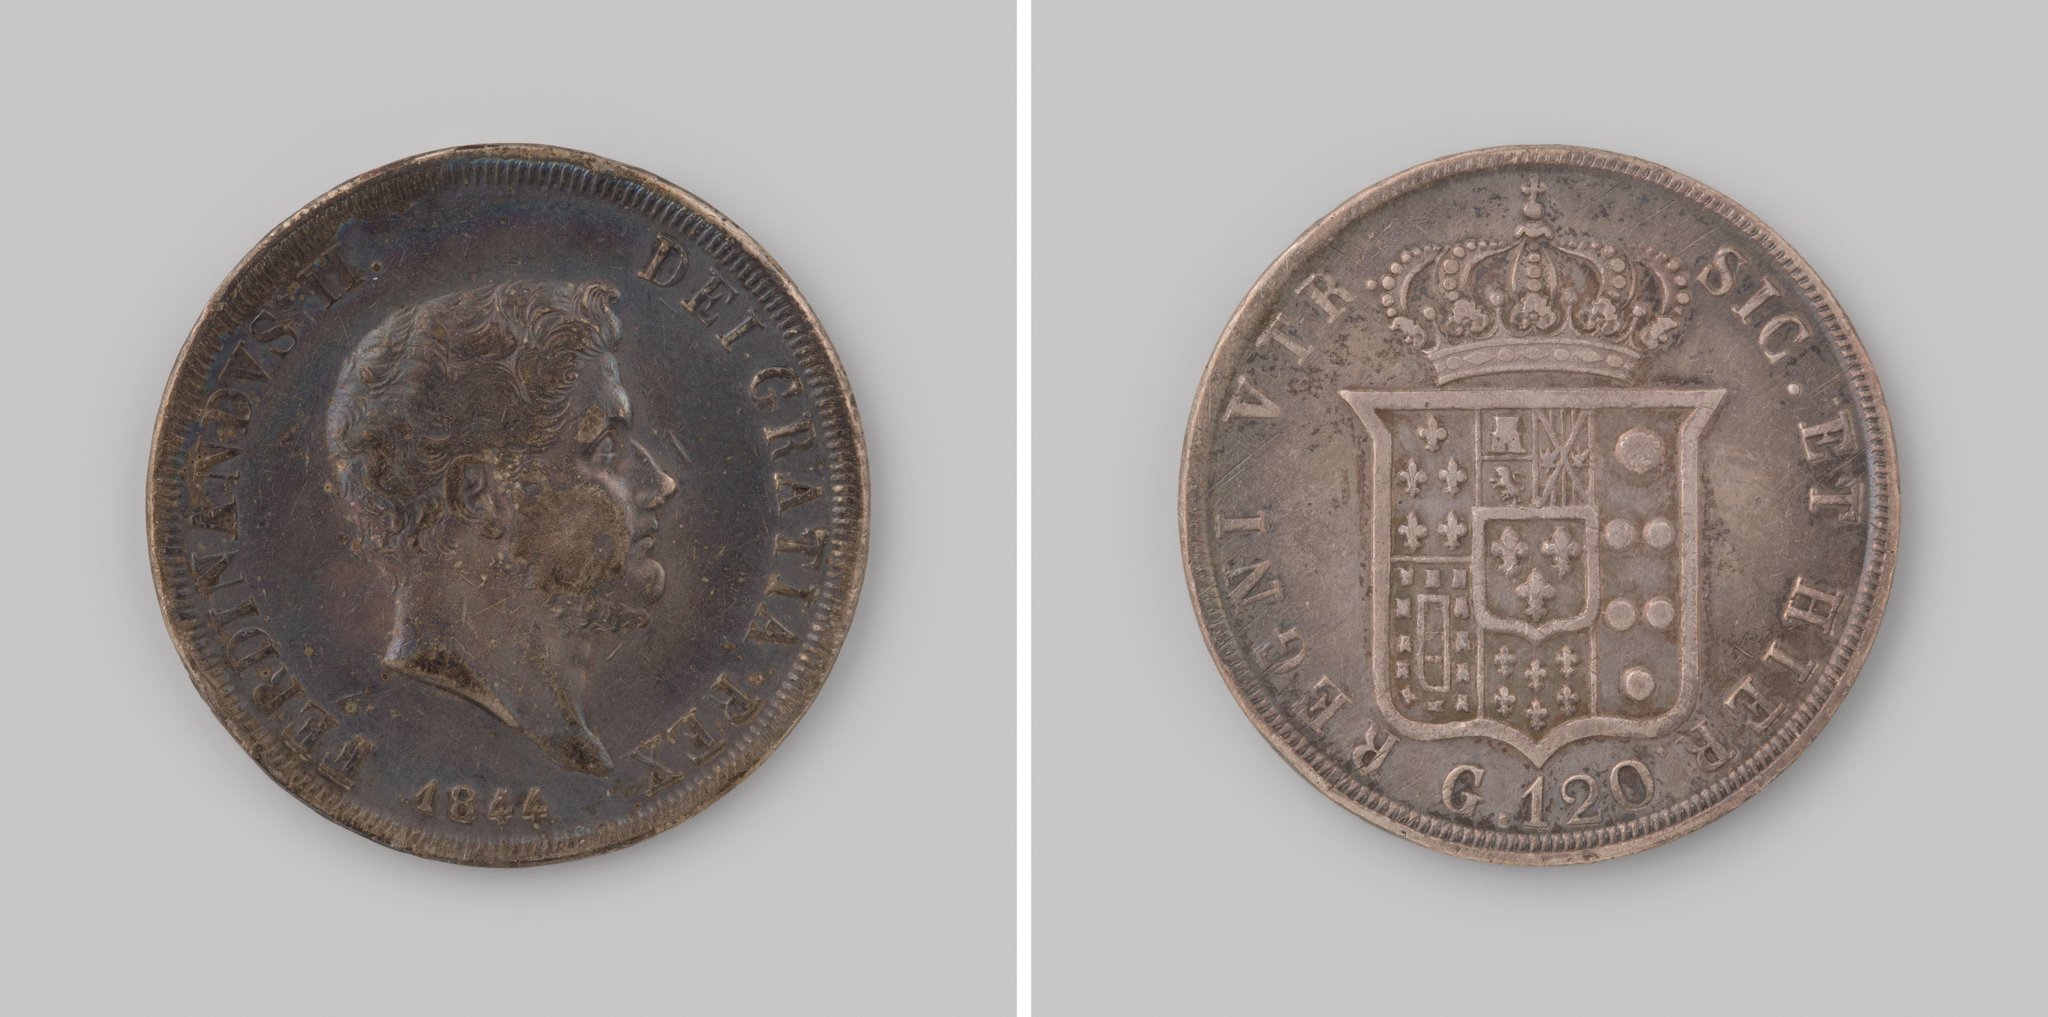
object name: coin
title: Koninkrijk der beide Siciliën, Ferdinando II, 120 grani, 1844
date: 1844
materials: silver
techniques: striking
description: Zilveren munt. Voorzijde: hoofd naar rechts. Jaartal onderaan. Keerzijde: gekroond samengesteld wapenschild. Waarde-aanduiding onderaan. Randschrift.